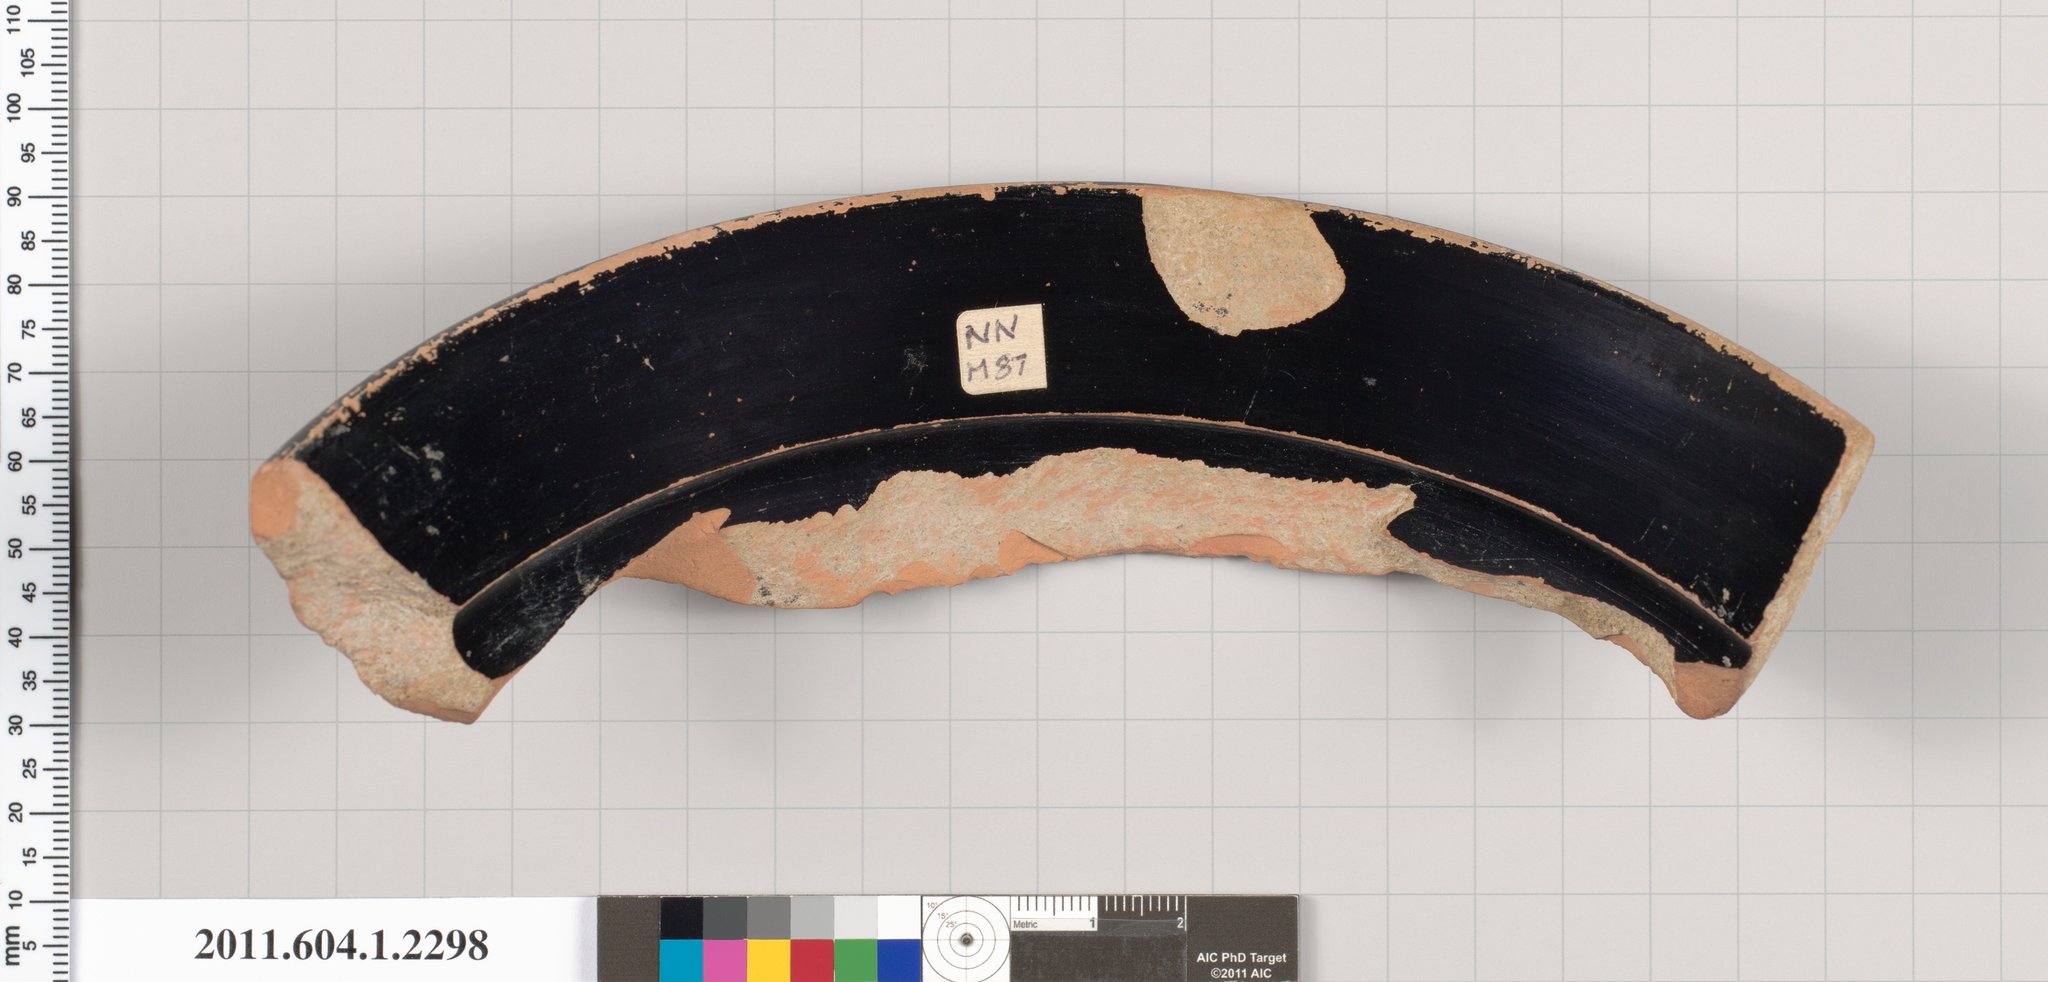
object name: kylix fragment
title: Terracotta fragment of a kylix (drinking cup)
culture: greek, attic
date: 475-451 BCE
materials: terracotta